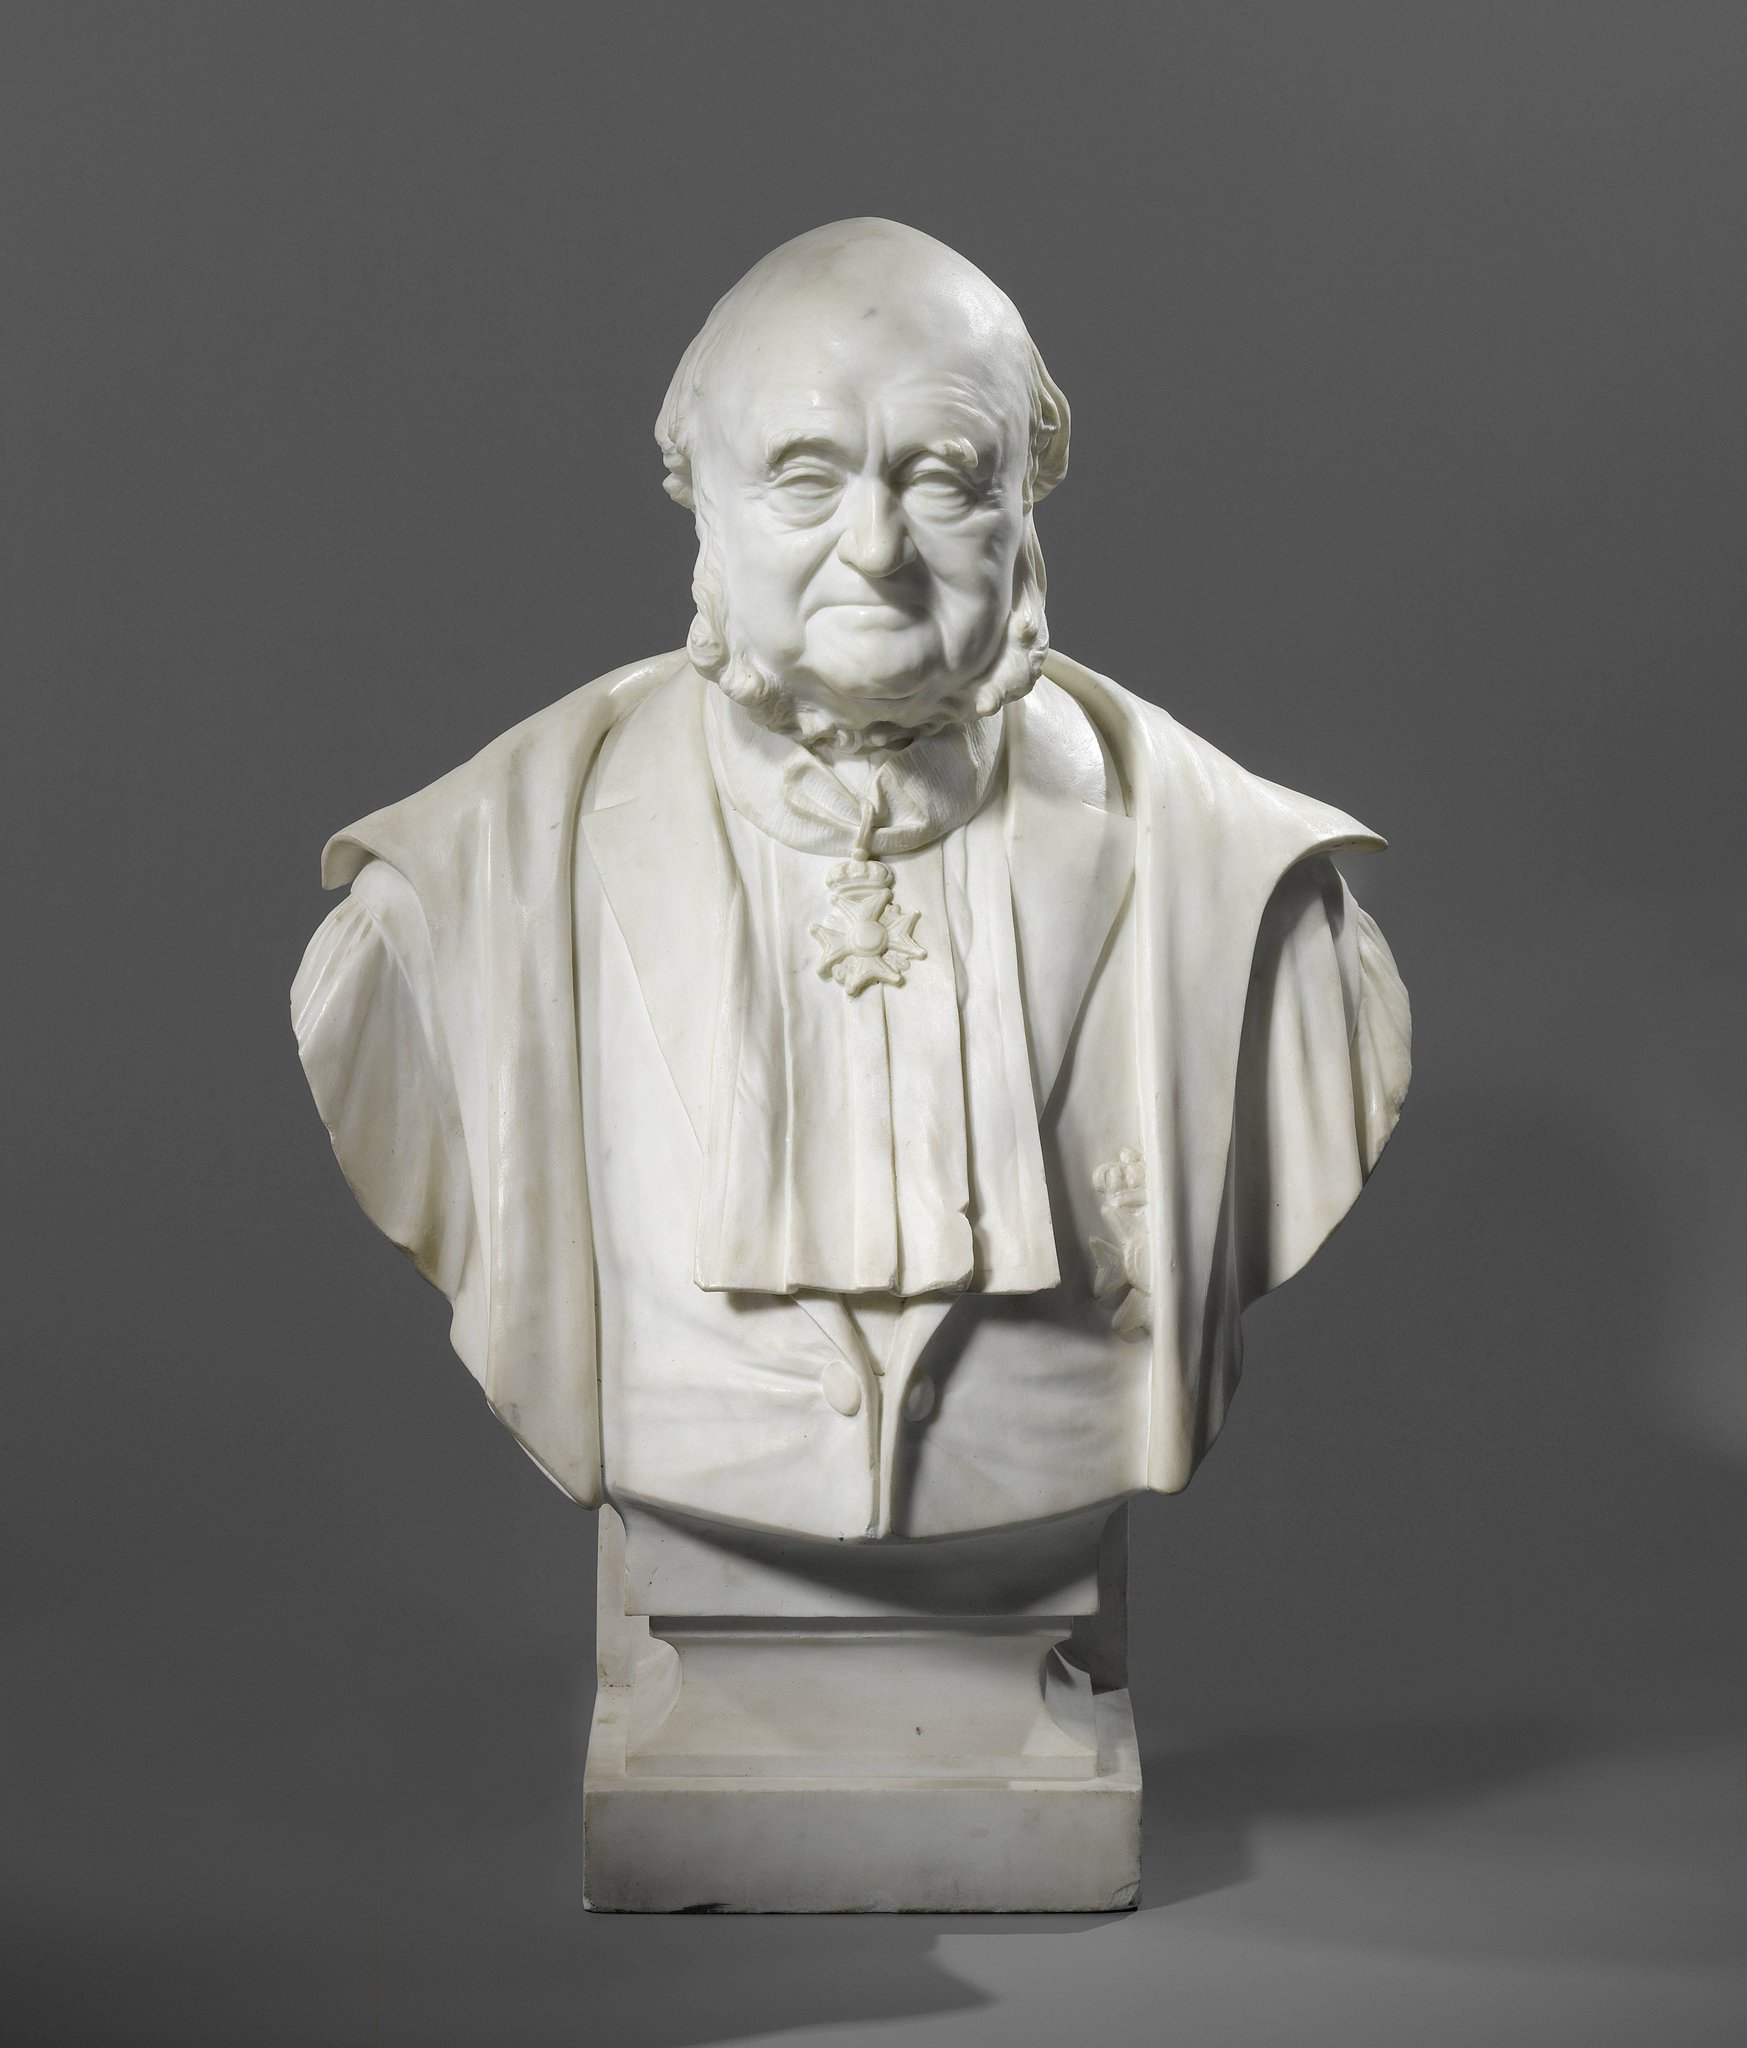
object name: bust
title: Buste van dr. Nicolaas Beets (1814-1903), letterkundige met sokkel van Rosso Asiago kalksteen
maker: cornelis beets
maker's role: sculptor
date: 1894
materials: marble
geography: netherlands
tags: haarlem, utrecht, nicolaas beets, portrait of a writer, historical persons (+ (full) bust portrait)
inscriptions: inscription: ‘Nicolaas Beets’, inscription: ‘Octogenarius’, inscription: ‘Nicolaas Beets // Poëta // Pastor // Professor // Pater Perfectus // Nat: 13 Sept. 1814 ob’, signature: ‘C. Beets 1894’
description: Buste van dr. Nicolaas Beets (1814-1903), letterkundige. Gemerkt: C. Beets 1894.